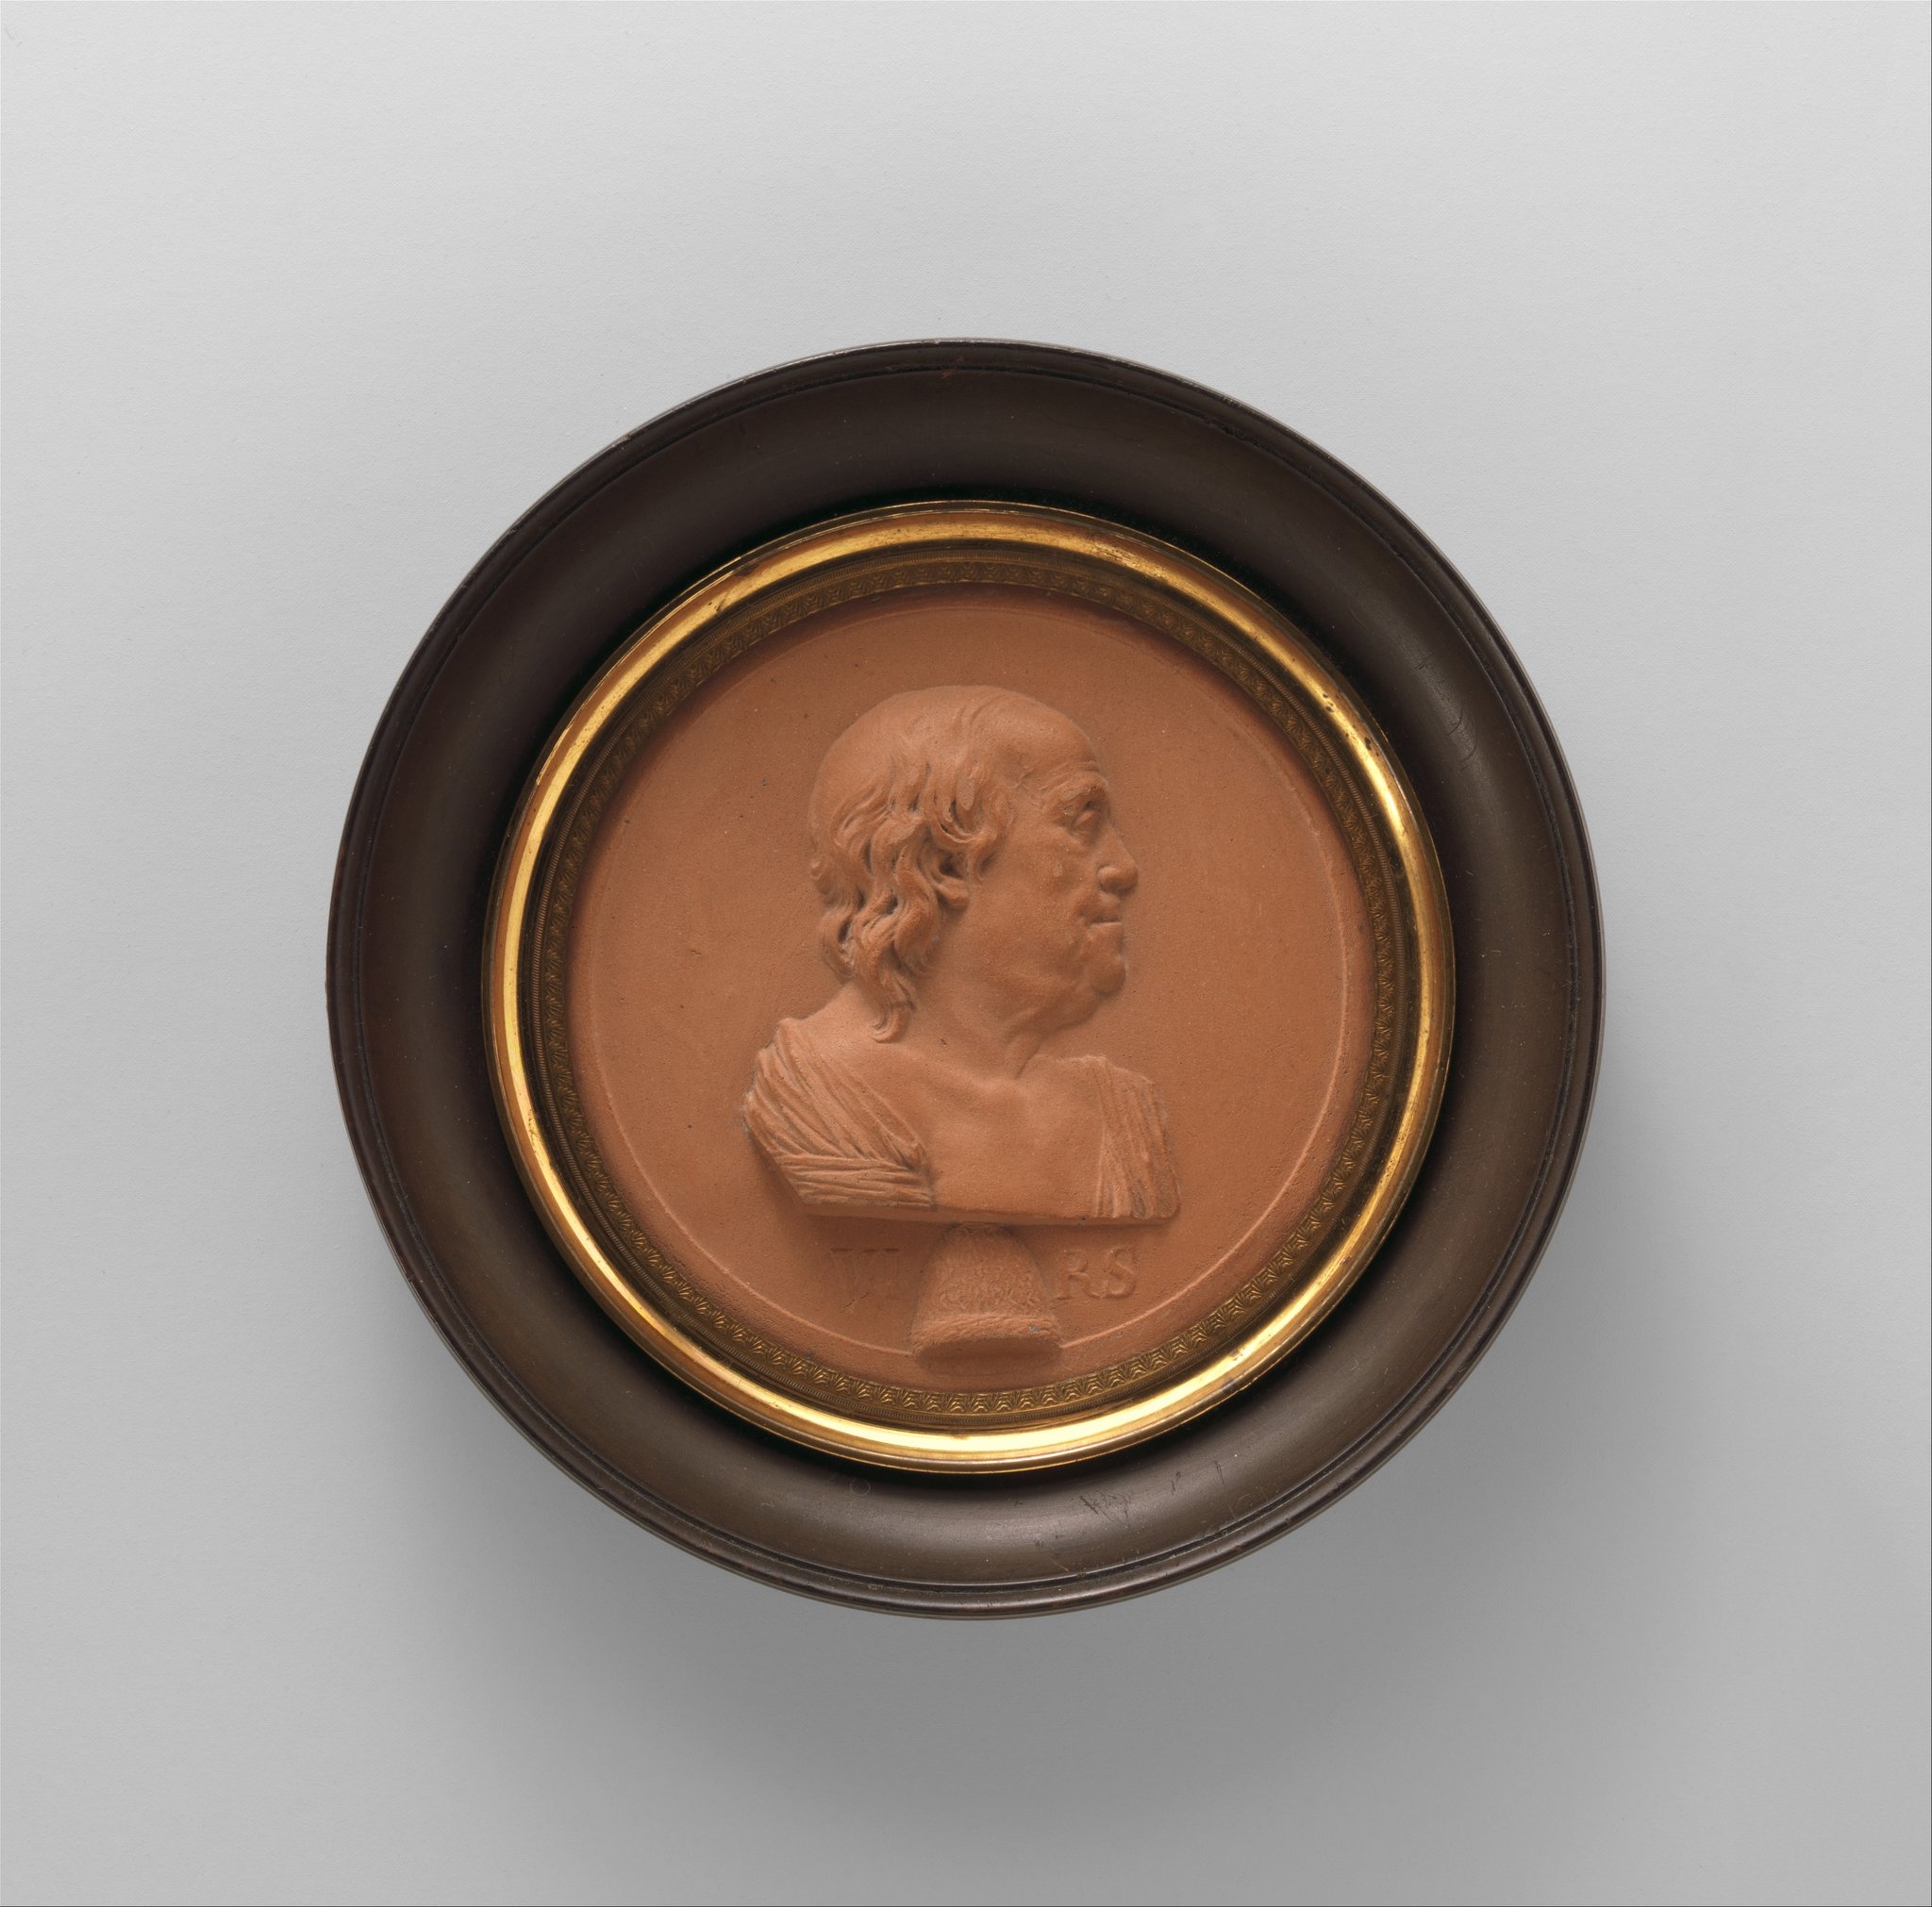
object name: plaque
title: Plaque of Benjamin Franklin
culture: french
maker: jean martin renaud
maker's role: maker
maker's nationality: french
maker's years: 1746-1821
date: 1797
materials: terracotta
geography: france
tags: benjamin franklin,profiles